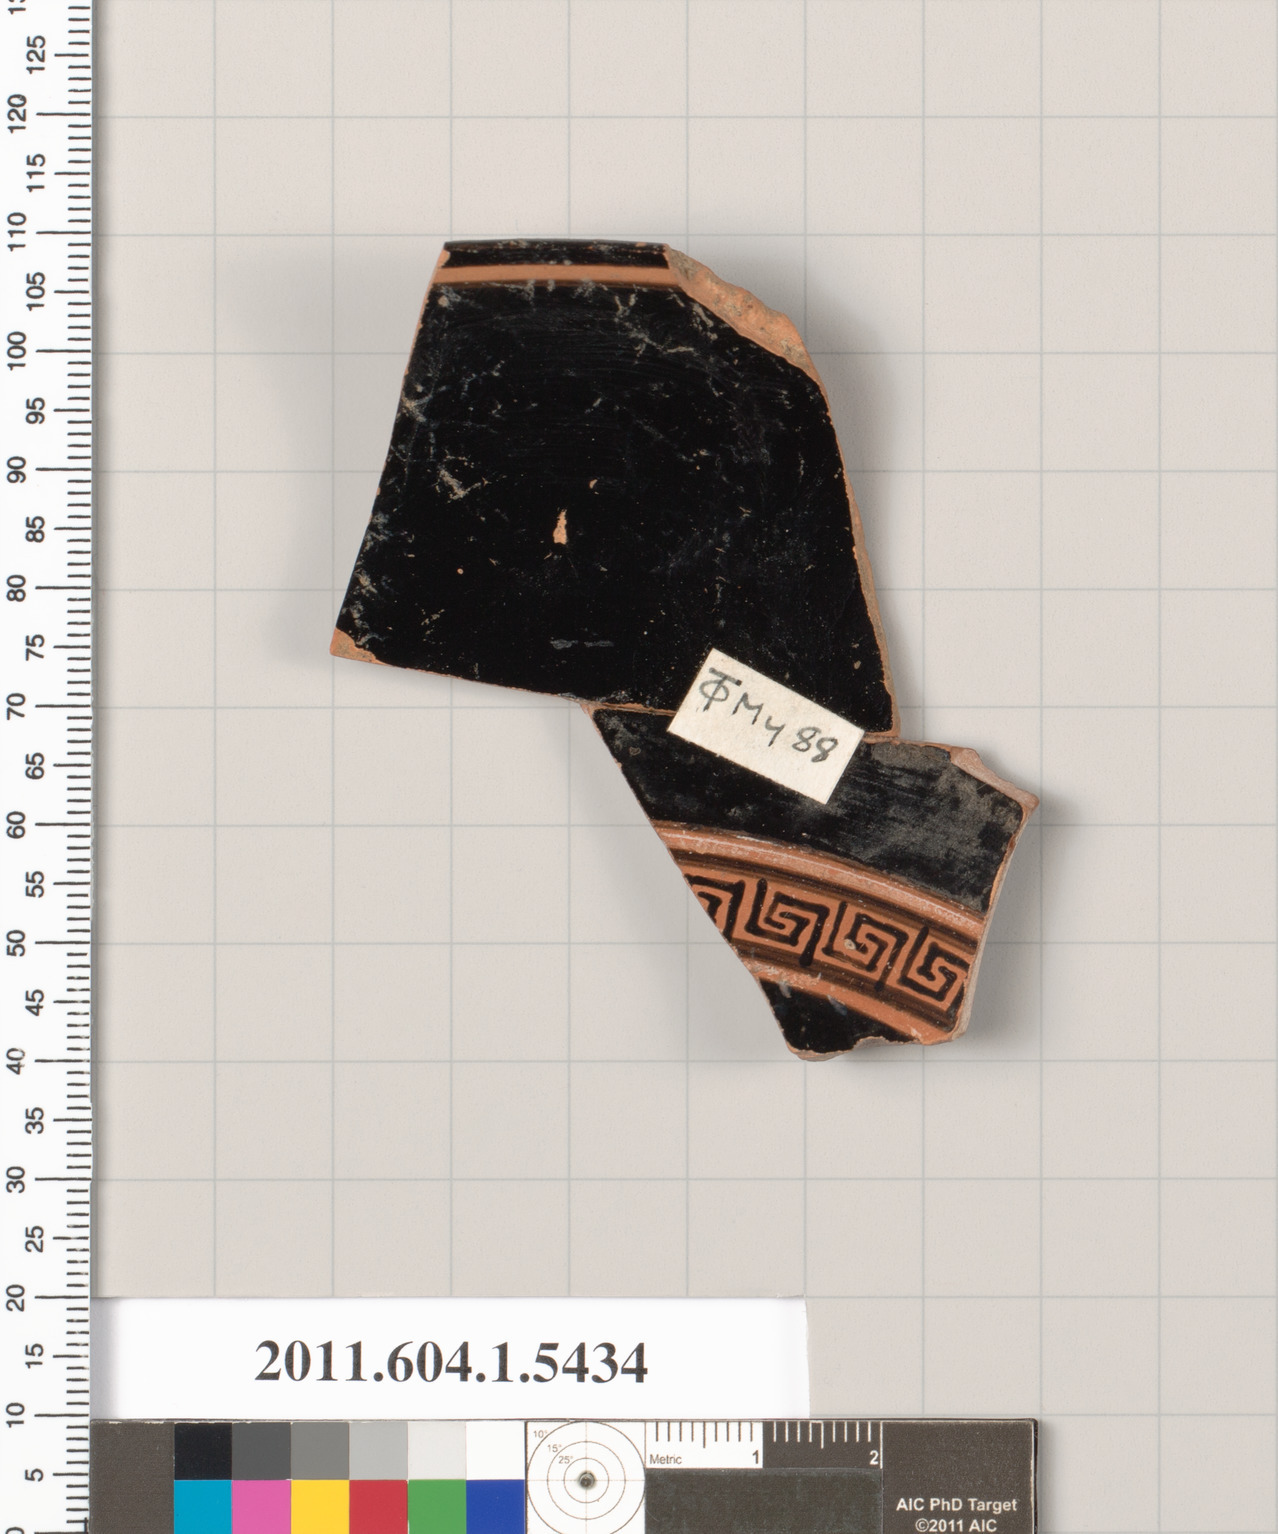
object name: kylix fragment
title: Terracotta rim fragment of a kylix (drinking cup)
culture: greek, attic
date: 475-451 BCE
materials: terracotta